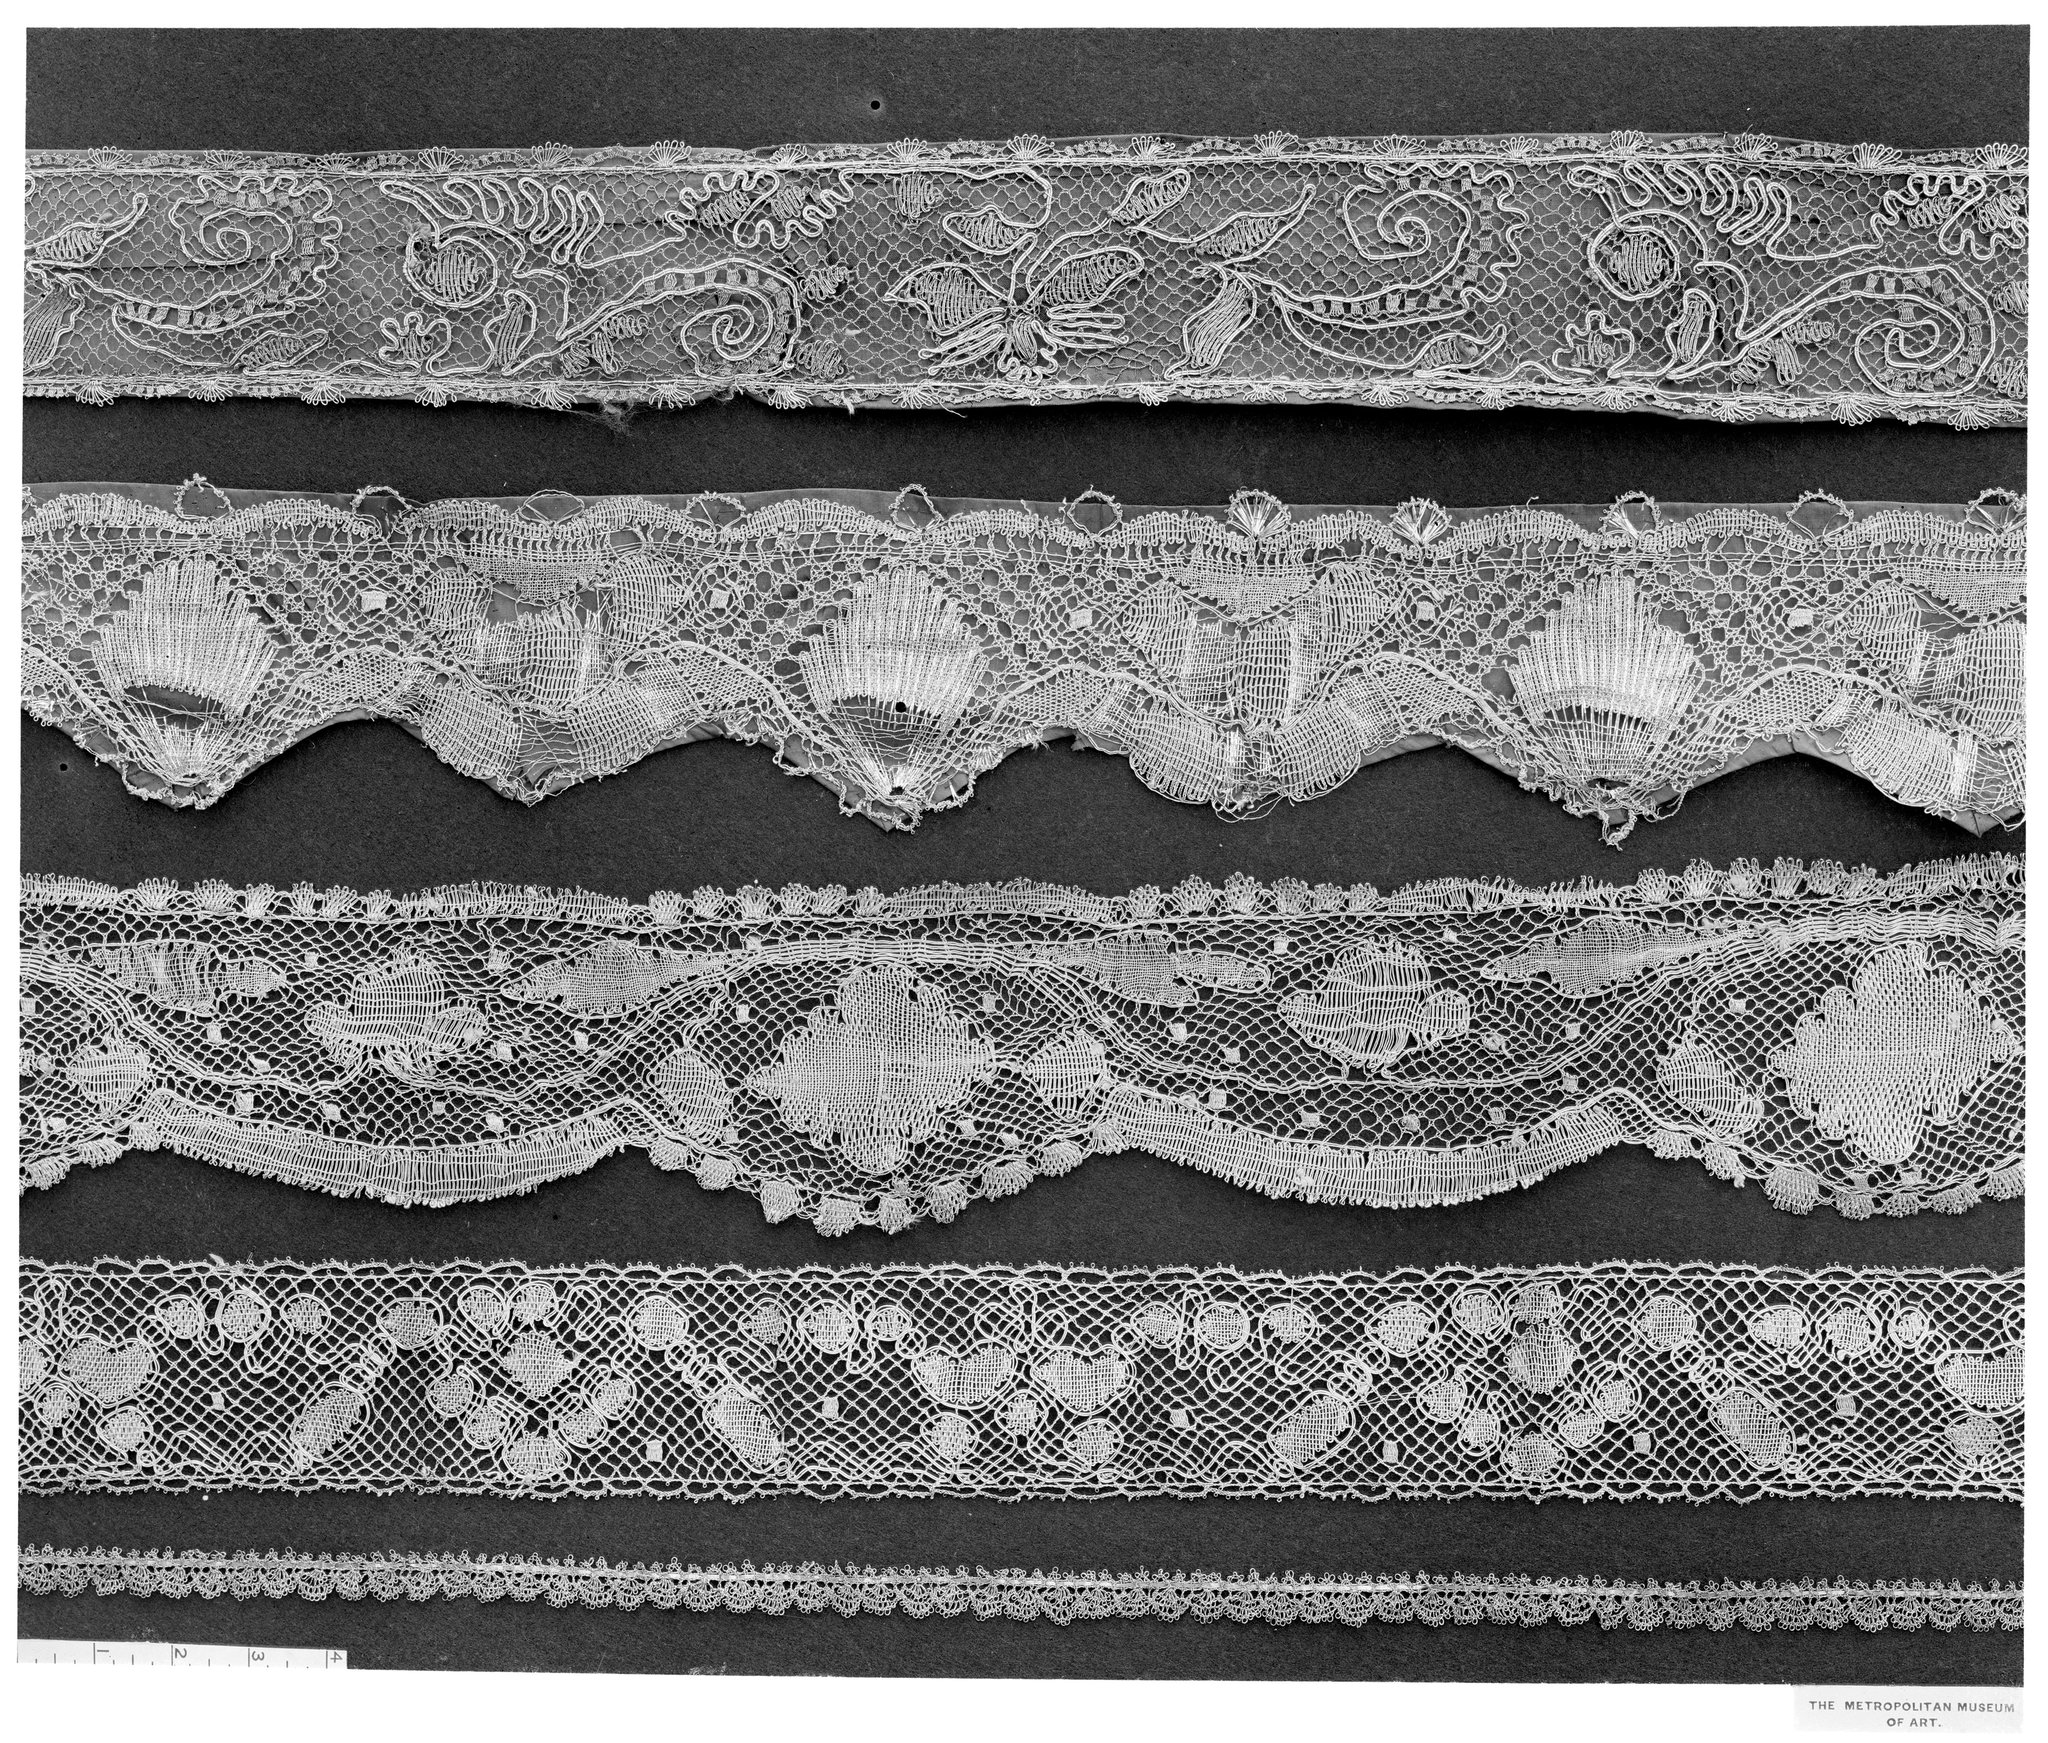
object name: piece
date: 1701-1800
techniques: lace